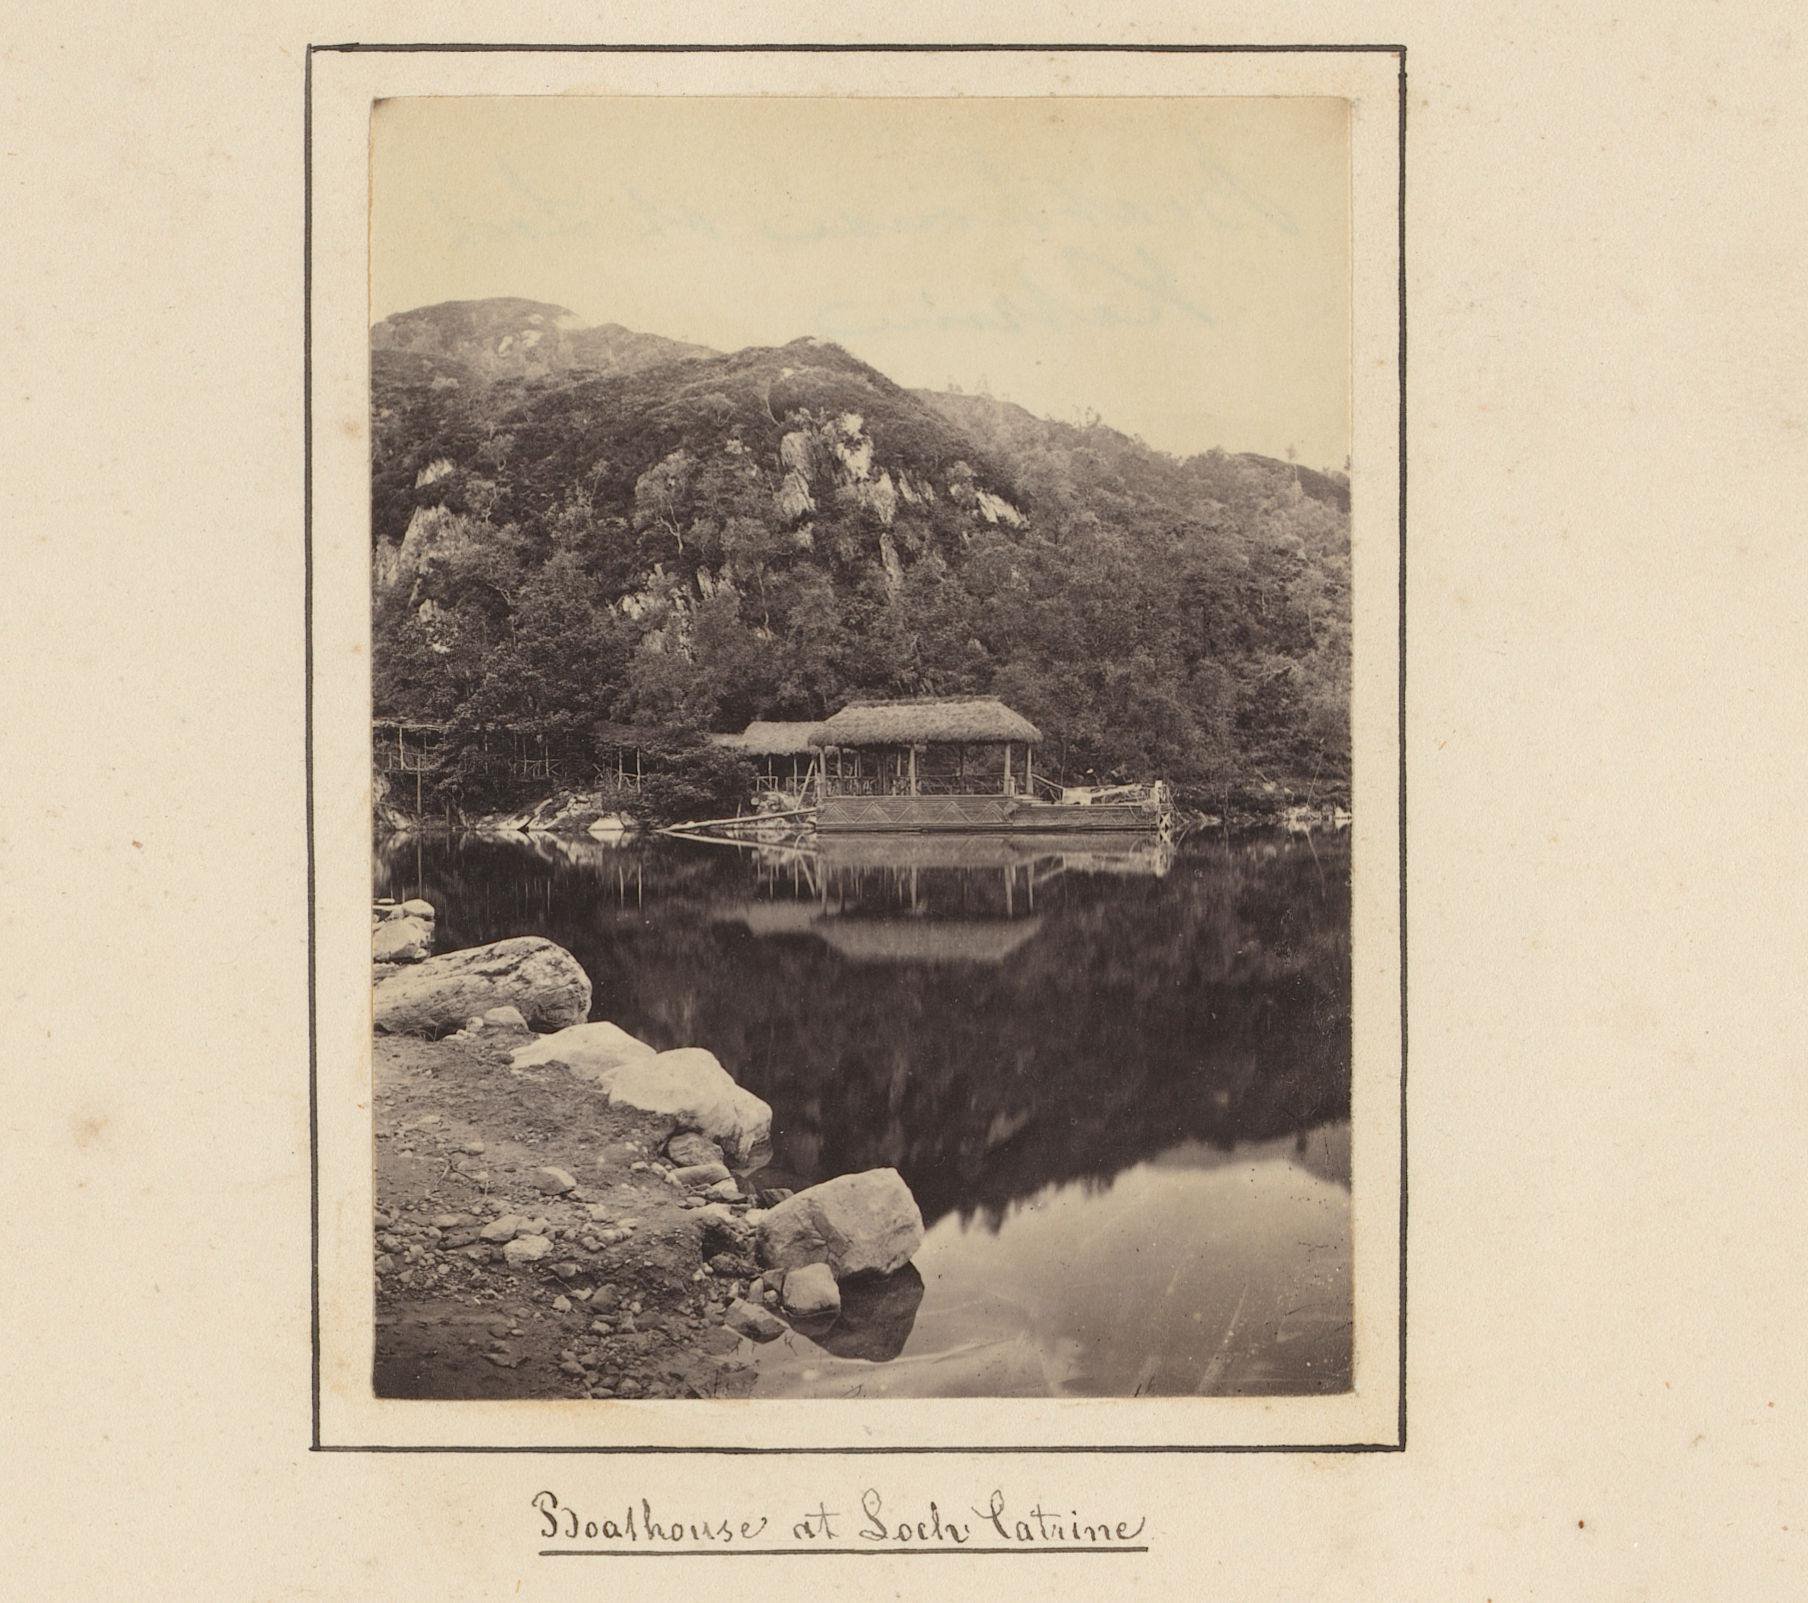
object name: photograph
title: Boothuis aan Loch Katrine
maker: Anonymous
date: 1870-1890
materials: paper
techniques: albumen print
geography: loch katrine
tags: lake, boat-house, shed